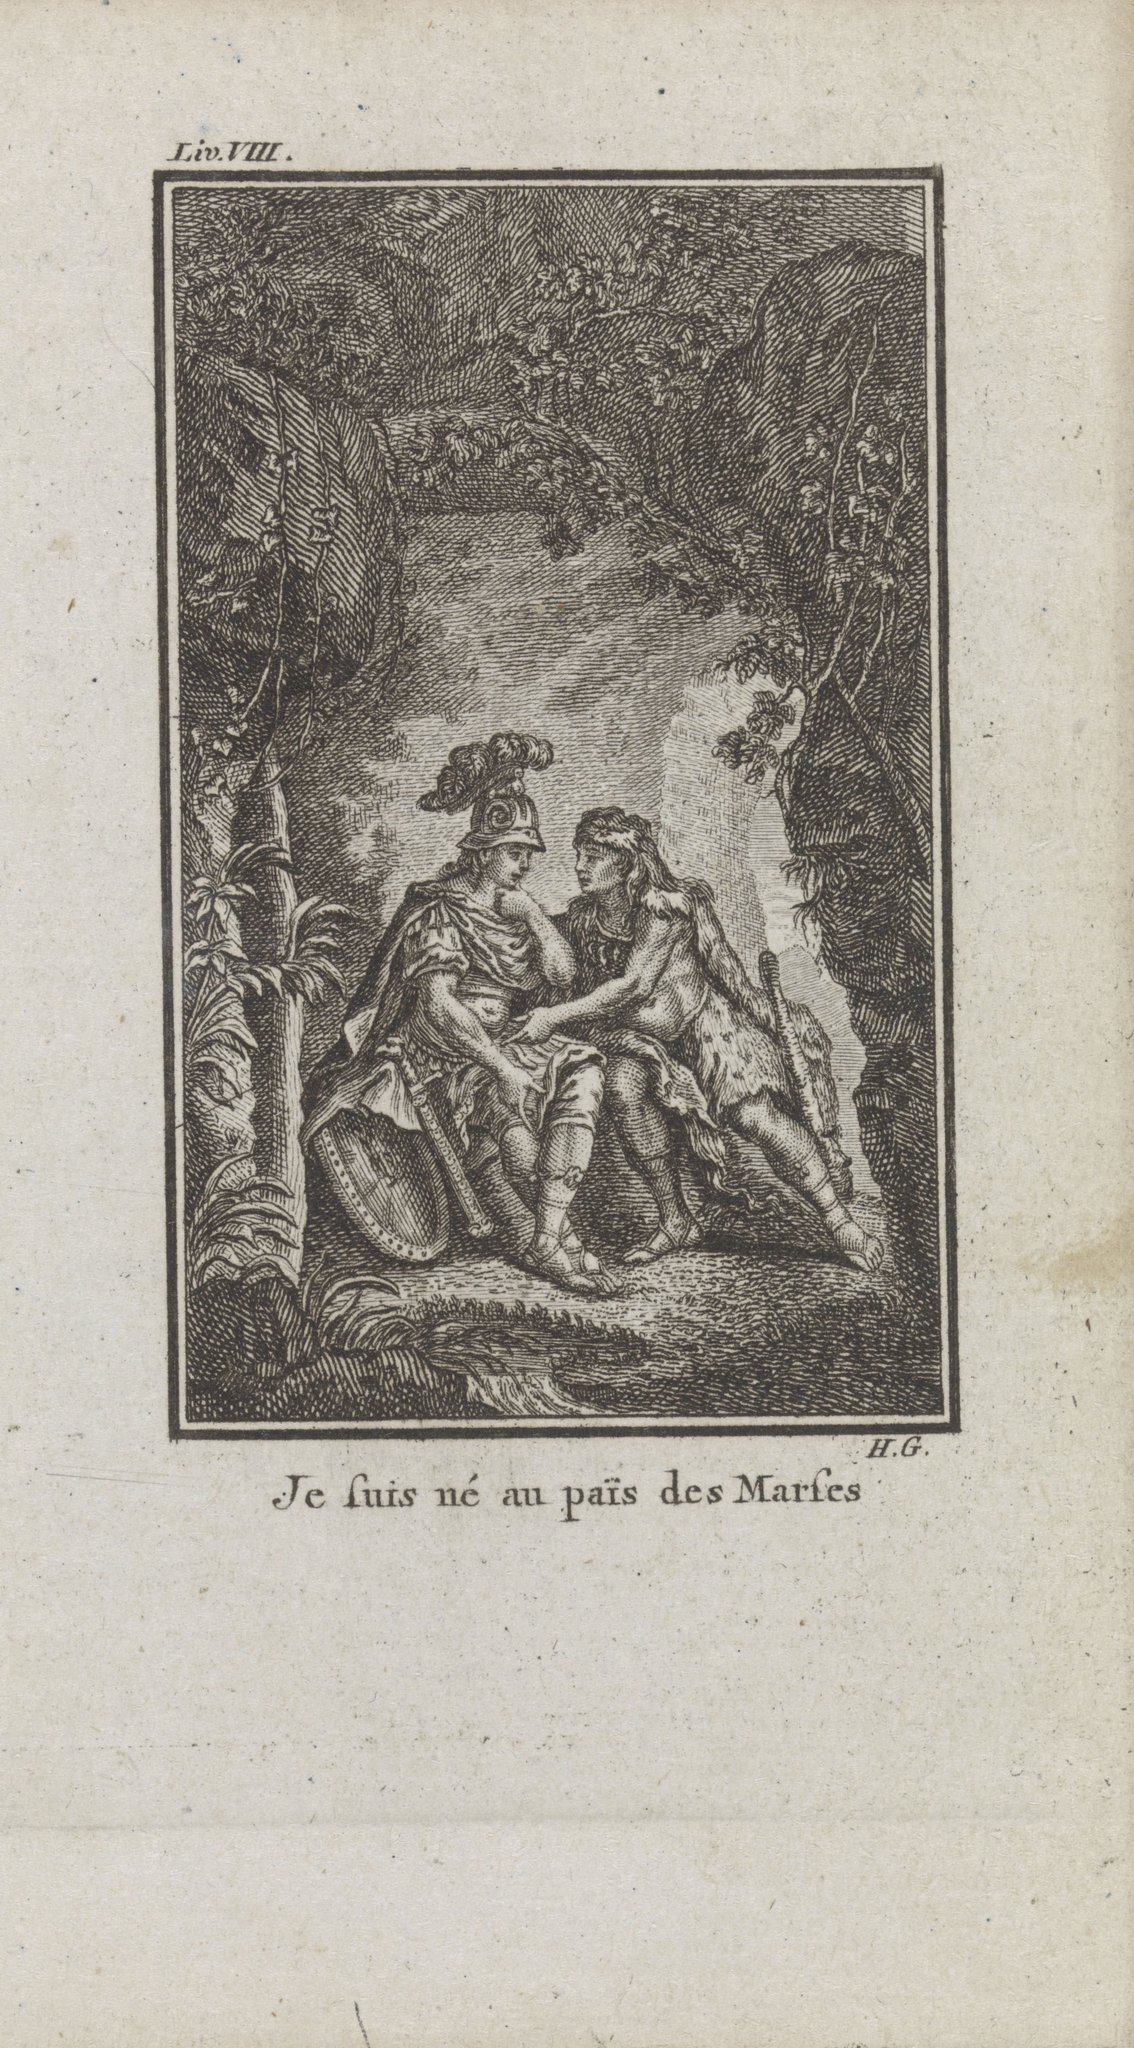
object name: print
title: Leo vertelt Numa zijn levensverhaal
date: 1790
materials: paper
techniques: engraving, letterpress printing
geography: liège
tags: deciduous forest, male literary characters (with name)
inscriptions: collector's mark: Lugt 2228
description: Boekillustratie voor Jean Pierre Claris de Florian, 'Numa Pompilius, second roi de Rome '. Brussel bij Benoît le Francq, 1790.